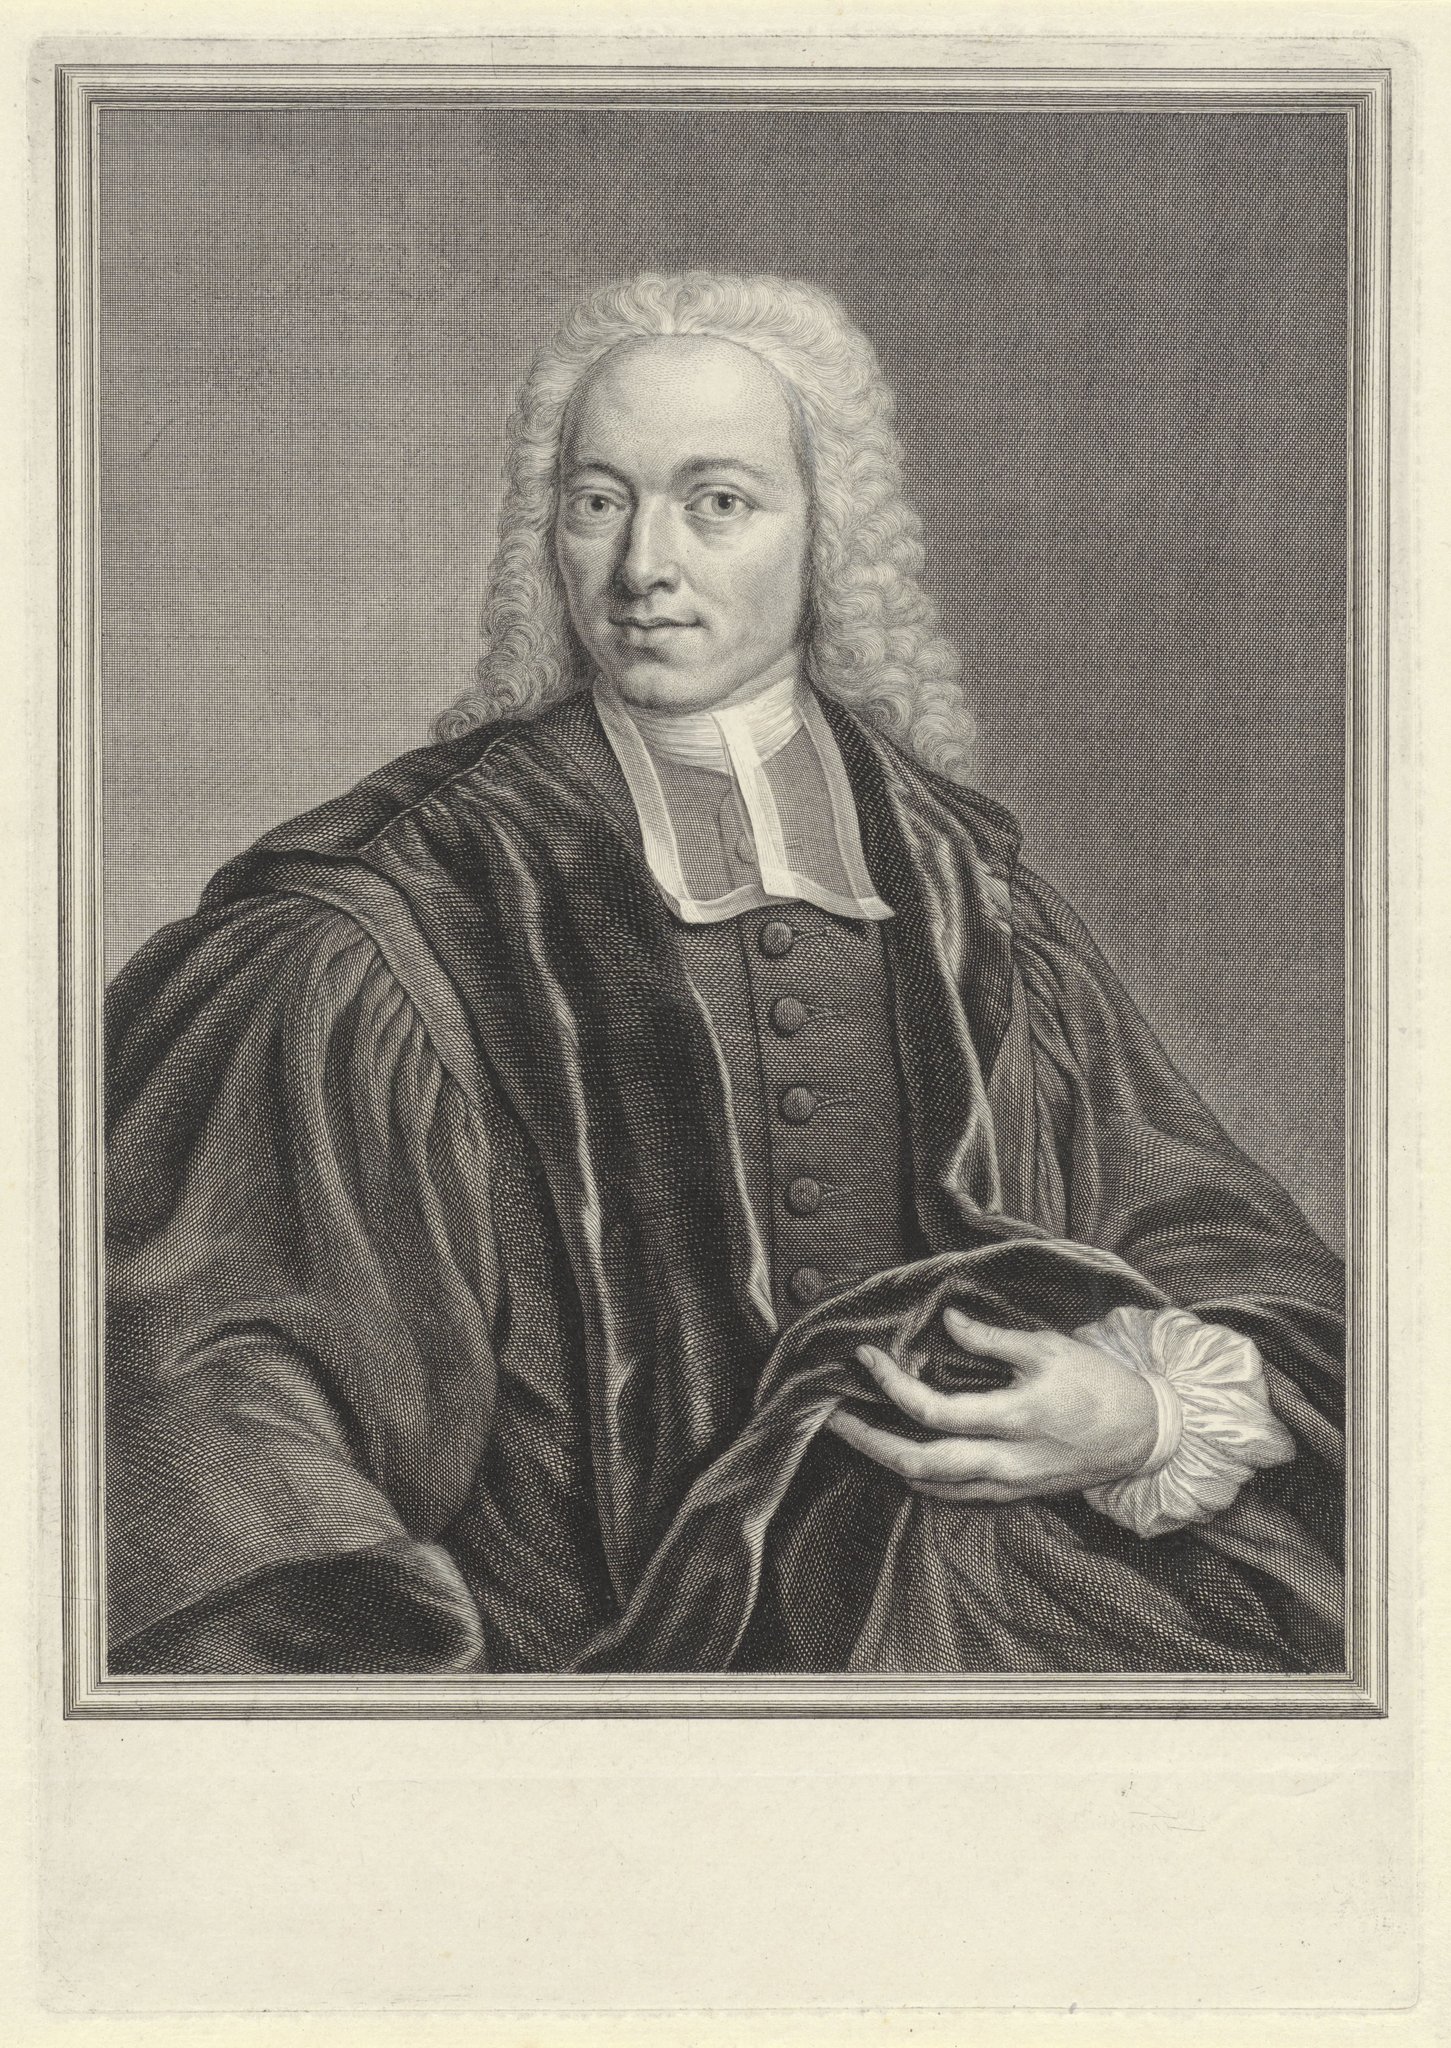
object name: print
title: Portret van Bernhardinus de Moor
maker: pieter tanjé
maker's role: draughtsman, print maker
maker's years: 1706-1761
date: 1748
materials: paper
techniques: engraving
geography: amsterdam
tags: gouda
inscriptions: collector's mark: Lugt 240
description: Portret van Bernhardinus de Moor, predikant en hoogleraar in de theologie te Leiden.